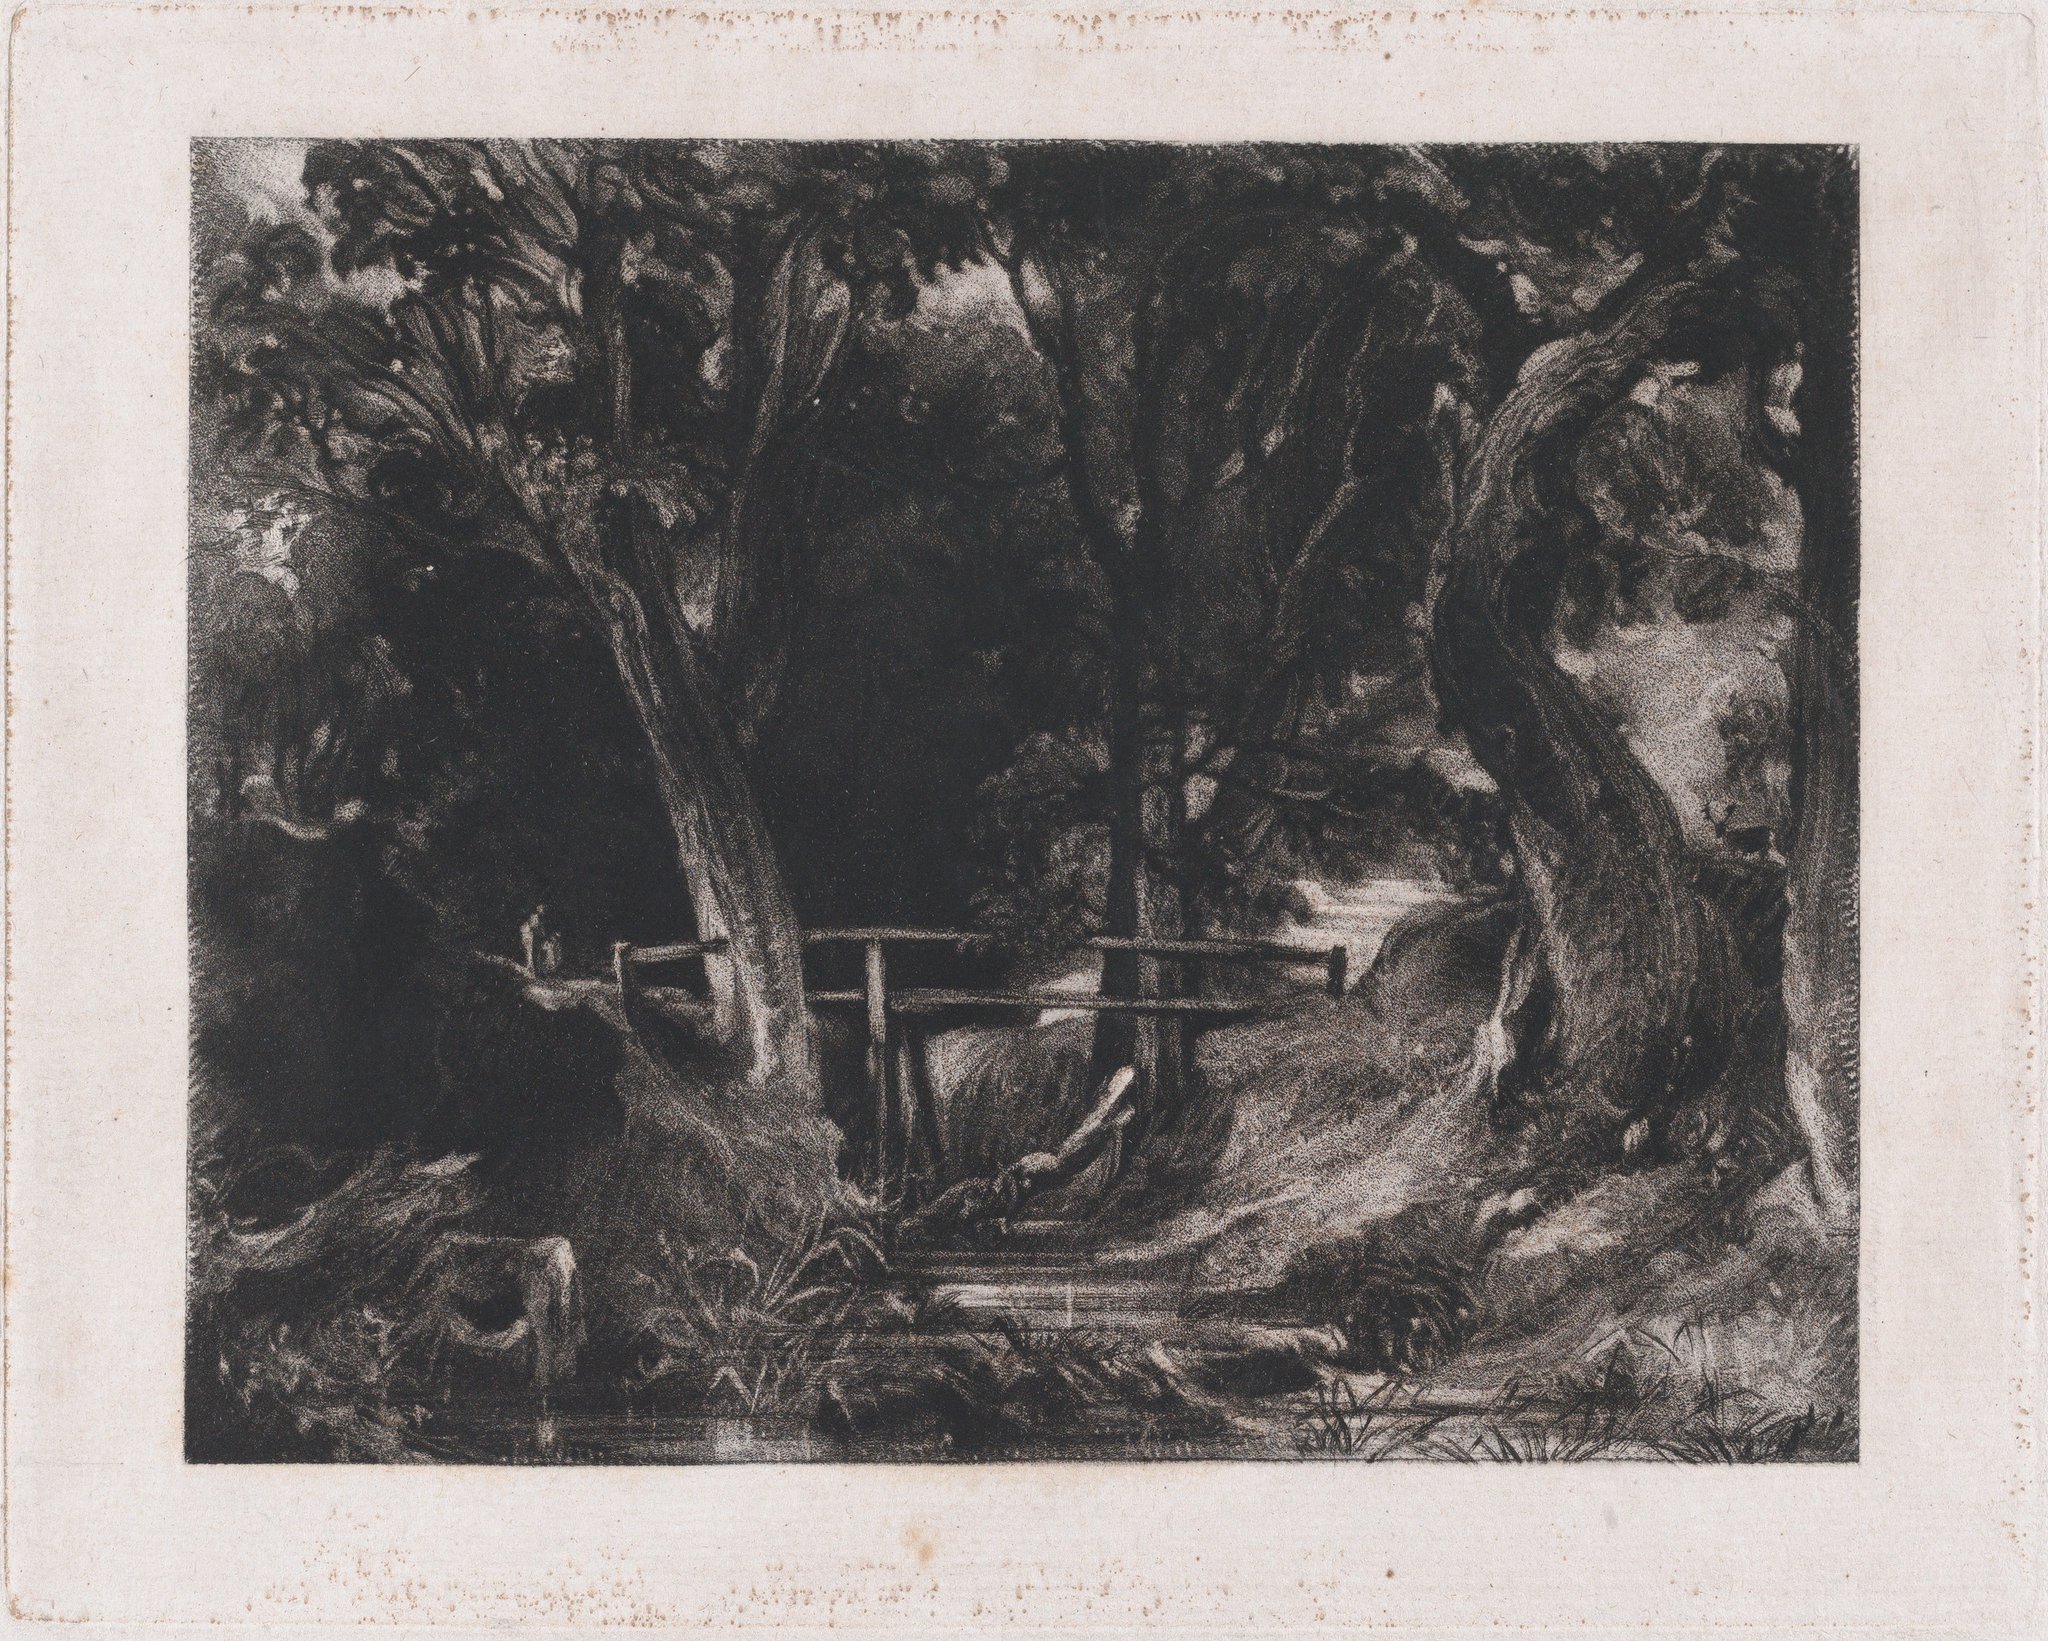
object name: print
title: A Dell, Helmingham Park, Suffolk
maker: david lucas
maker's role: artist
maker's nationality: british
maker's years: 1802-1881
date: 1830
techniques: mezzotint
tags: bridges,parks